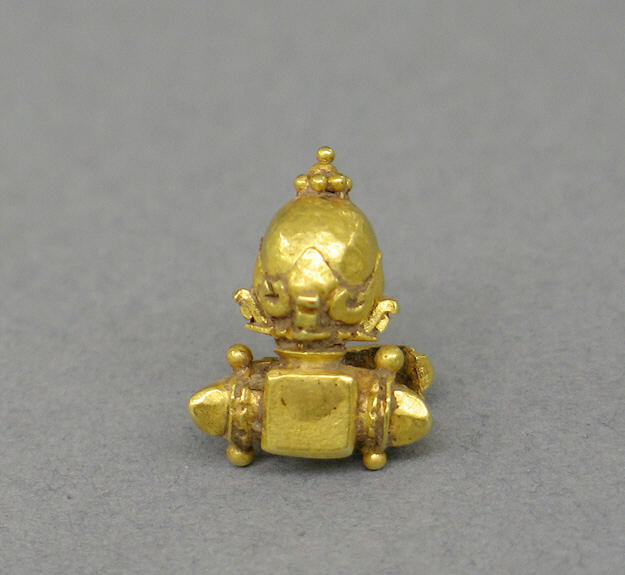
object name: ear clip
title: Pair of Ear Clips with Foliate Motifs and Granulate Designs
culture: indonesian, javanese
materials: gold